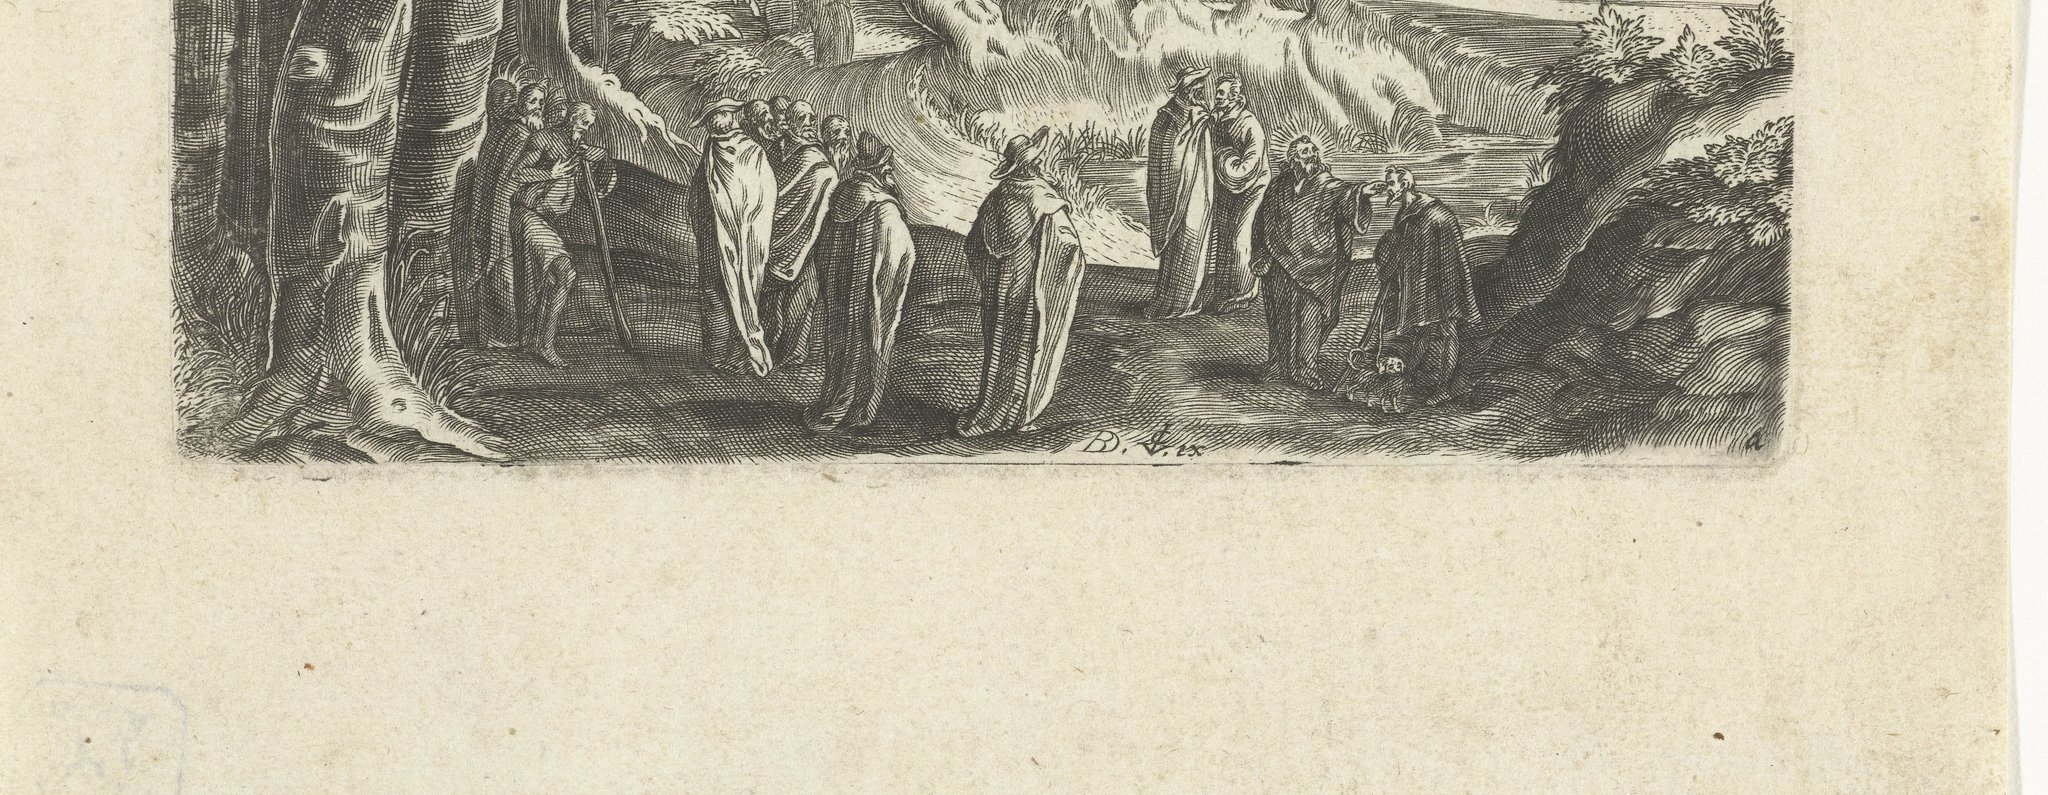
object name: print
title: Christus met zijn discipelen in het bos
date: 1589-1626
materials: paper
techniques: engraving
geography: amsterdam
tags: christ's prayer for his apostles (john 17:1-26)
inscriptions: collector's mark, collector's mark: Lugt 2228, collector's mark: ‘E.J.’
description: Christus staat met zijn discipelen op een open plek in het bos bij een meertje.